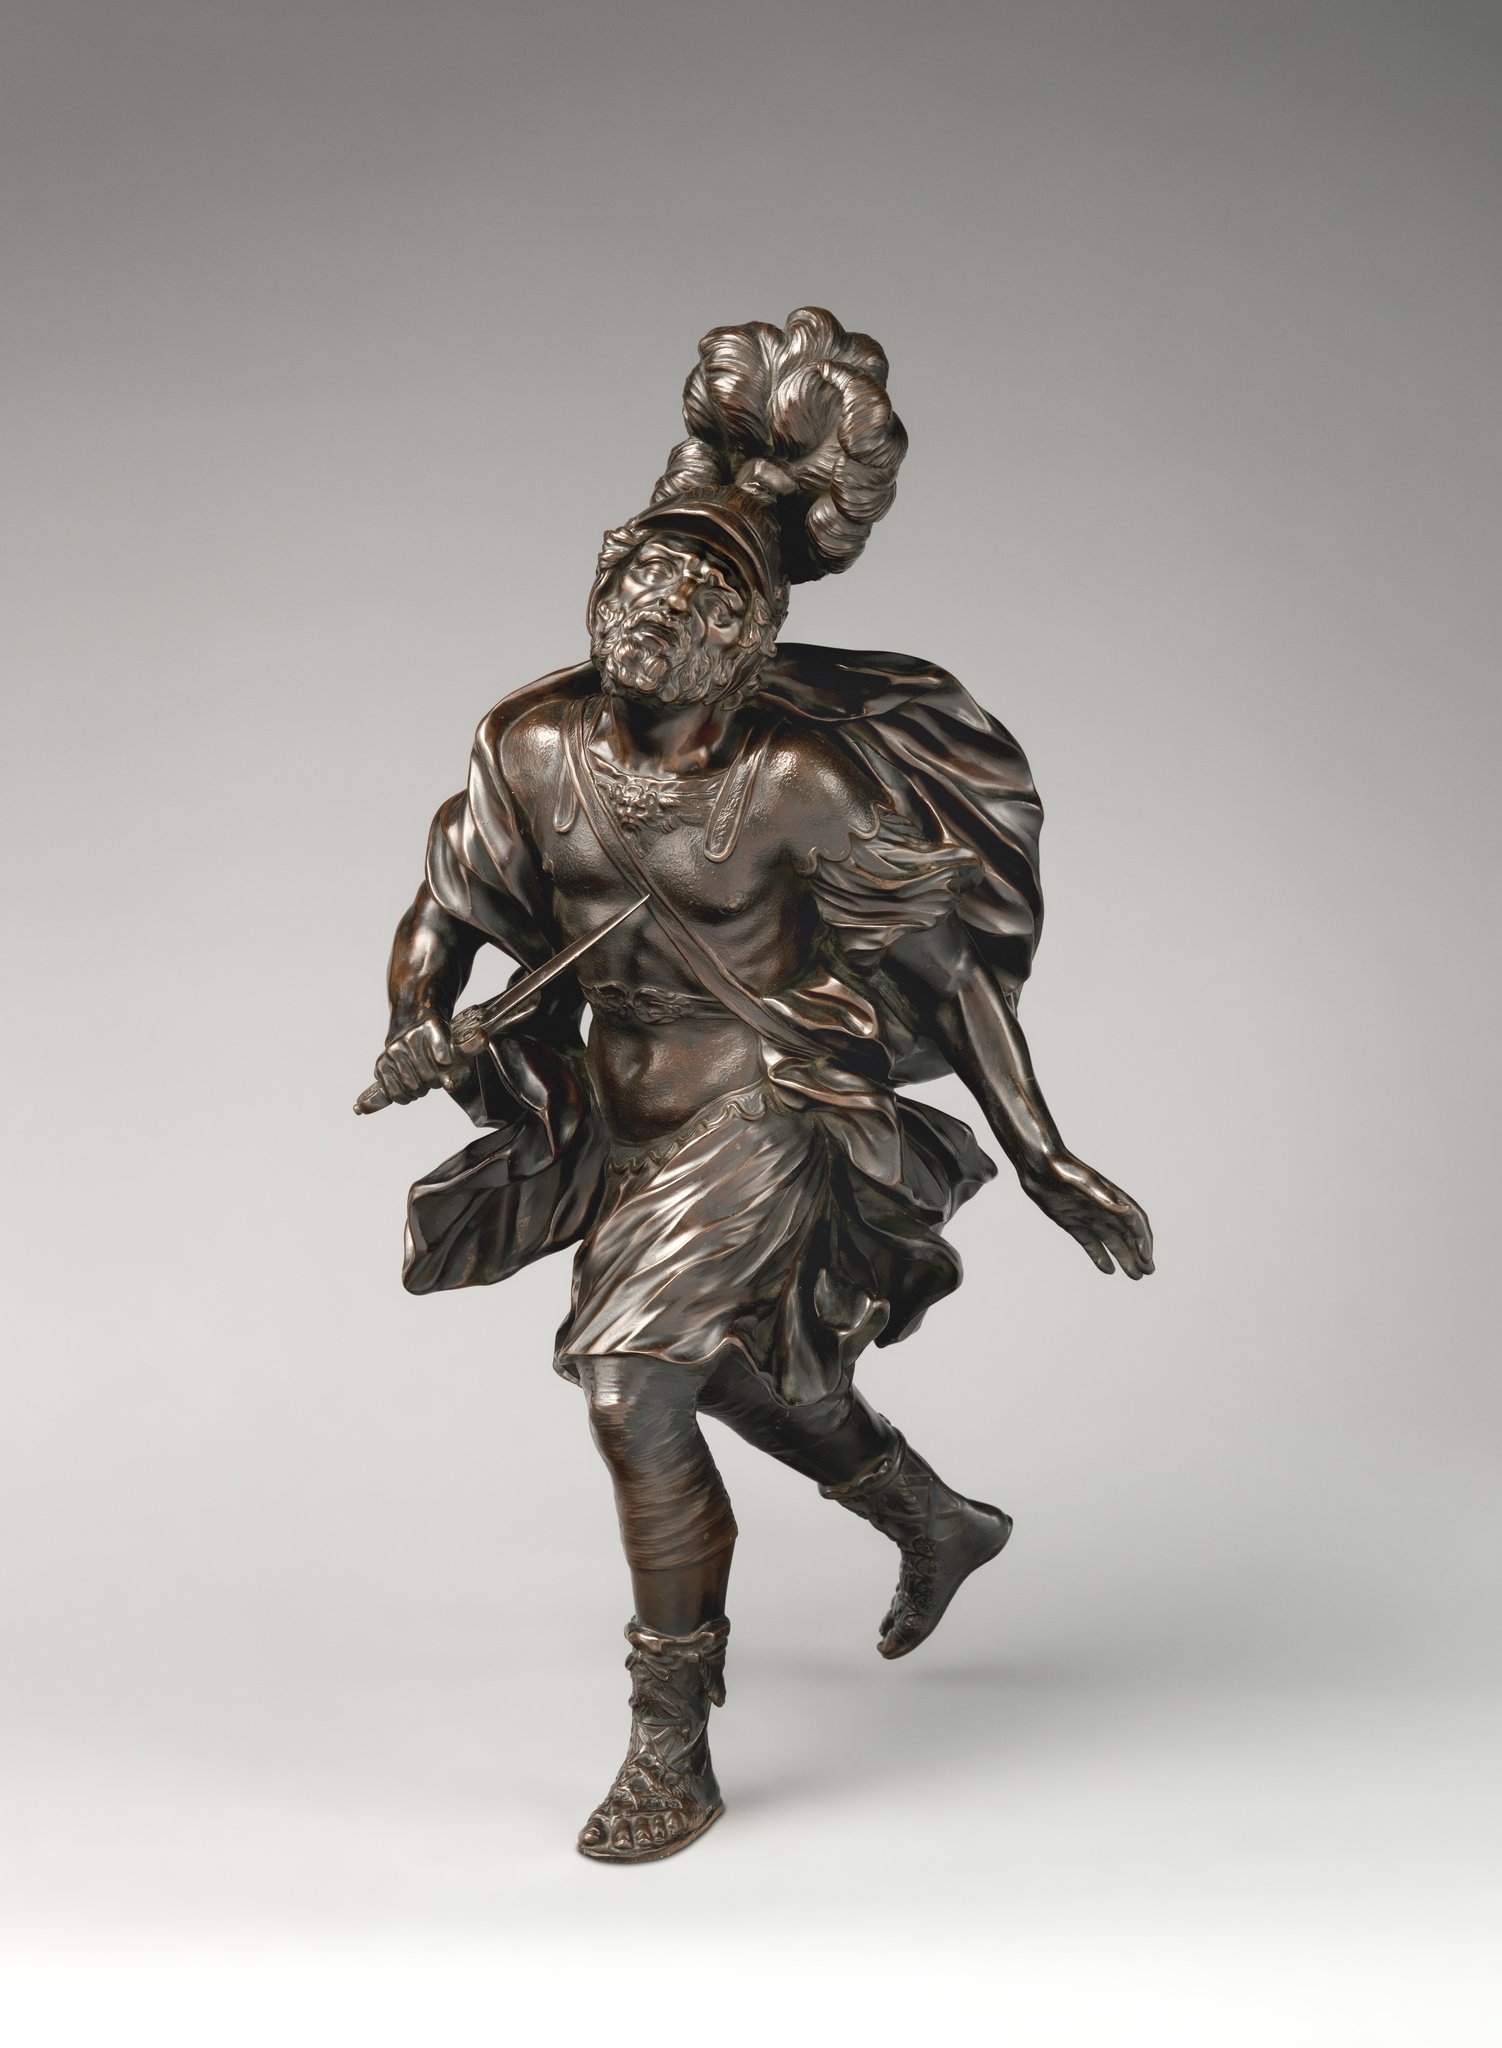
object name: statuette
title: The suicide of Ajax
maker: giovanni battista foggini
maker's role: artist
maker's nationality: italian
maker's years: 1652-1725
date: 1690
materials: bronze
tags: knives,men